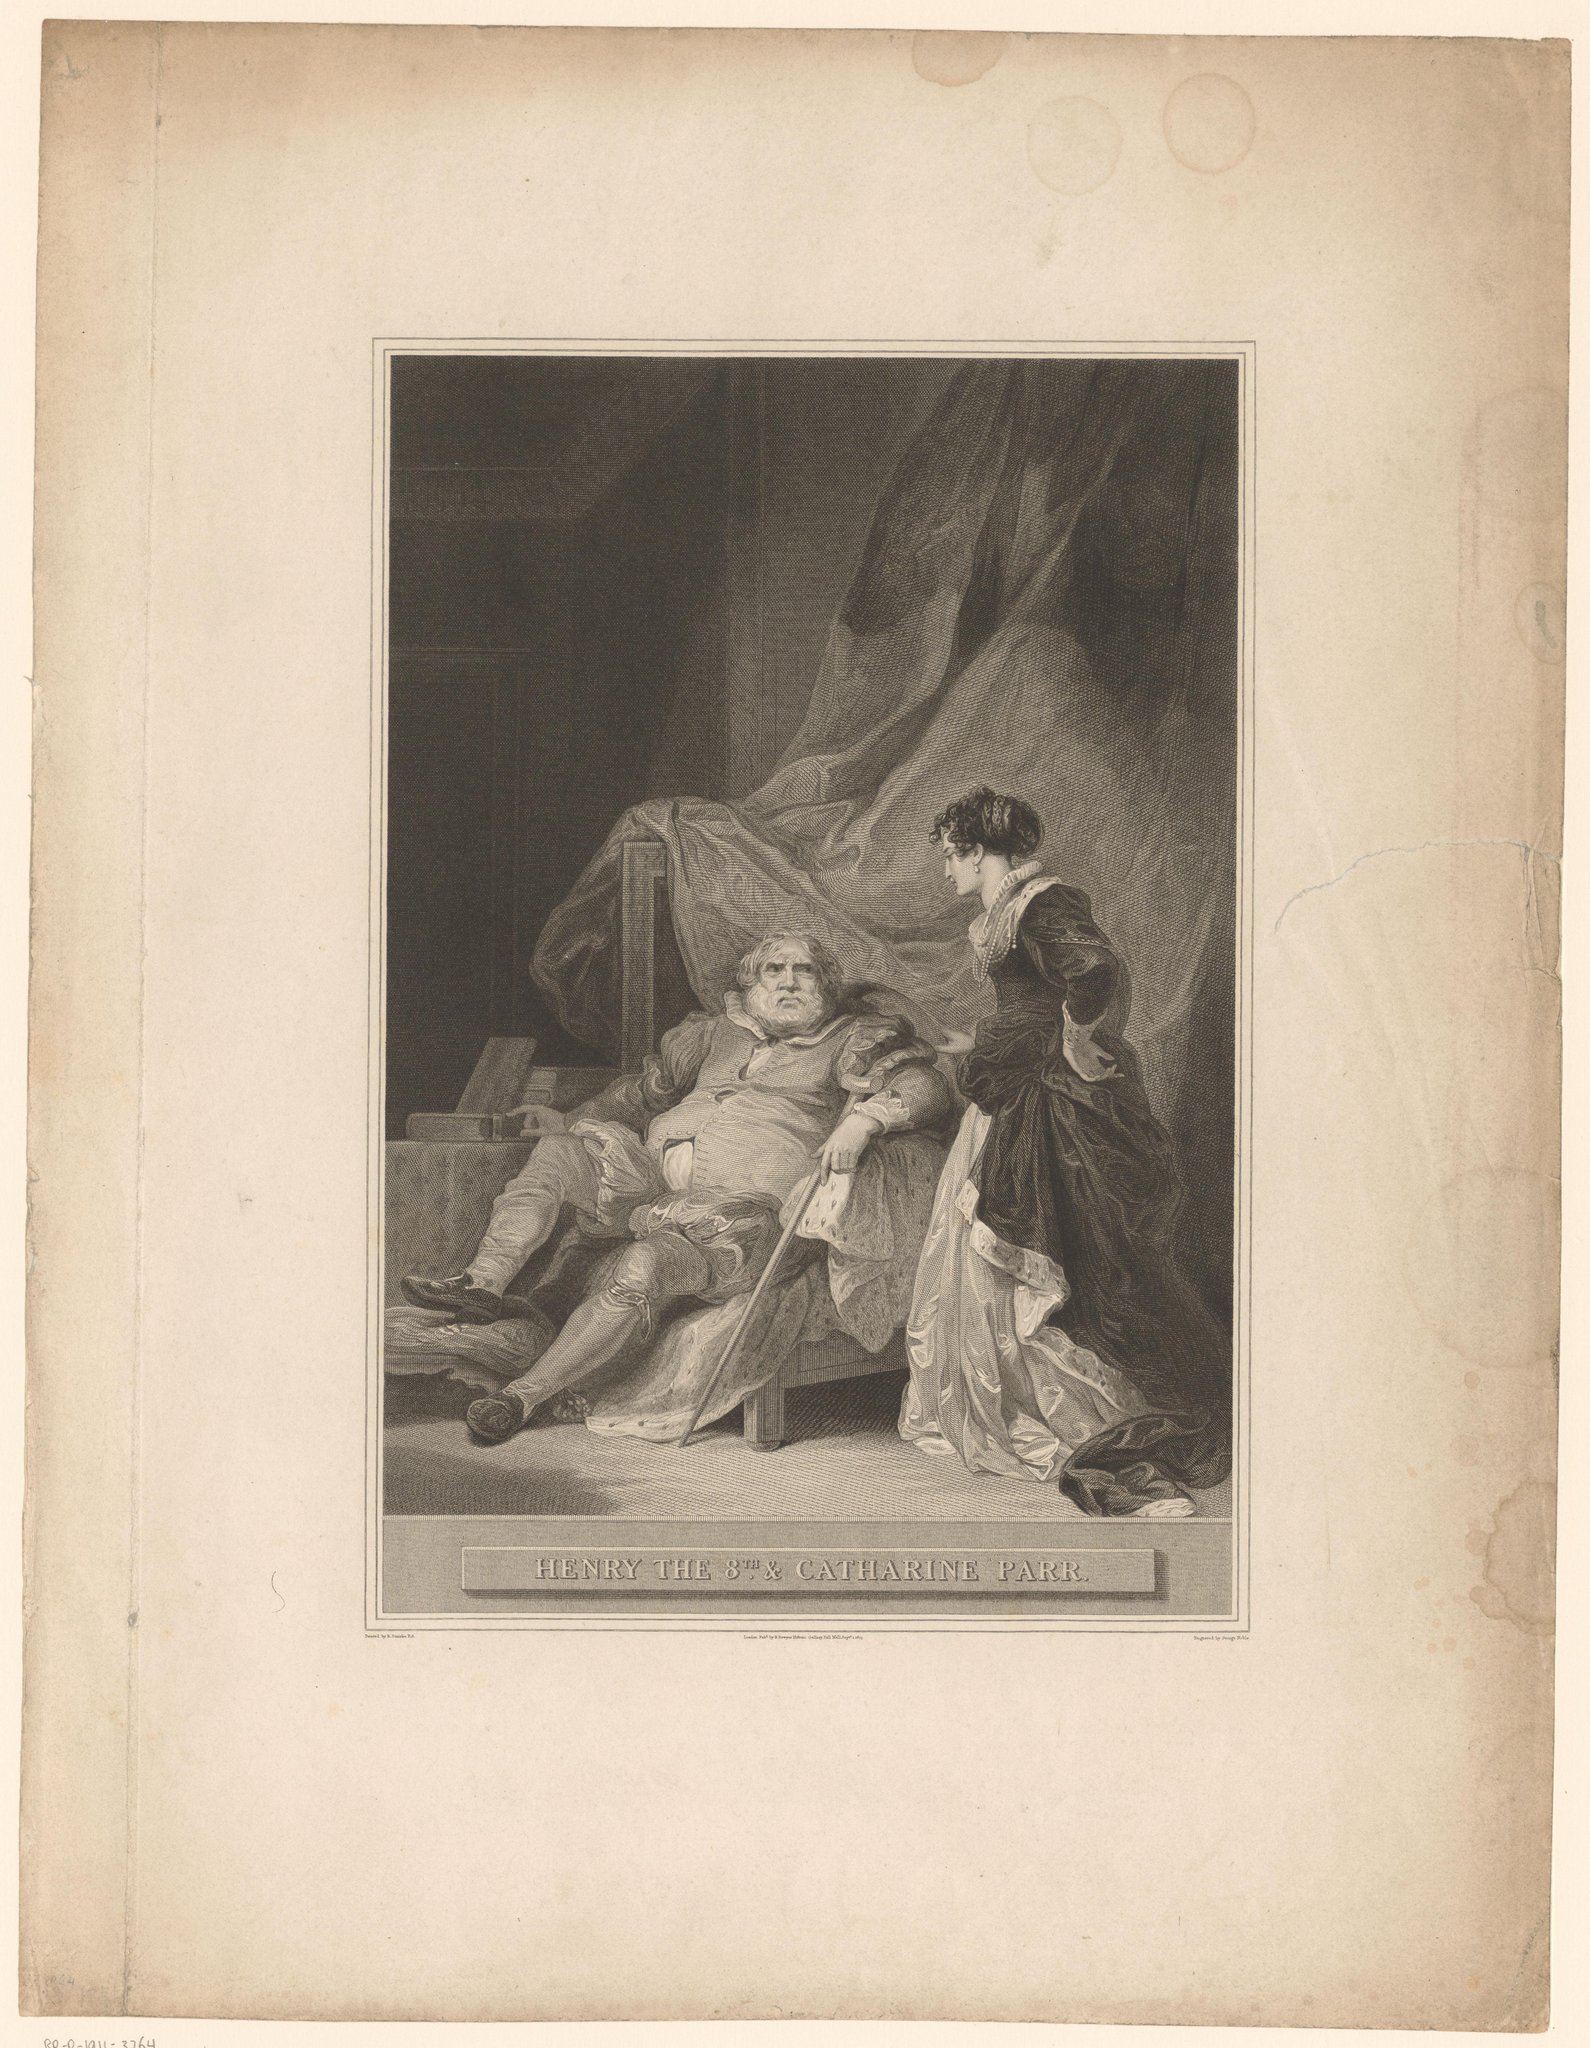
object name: book illustration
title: Henry the 8th. & Catharine Parr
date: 1805-1809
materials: paper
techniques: etching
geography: london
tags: queen, king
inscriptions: collector's mark: Lugt 2228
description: Prent uit: Hume, David. History of England (...). Londen: Robert Bowyer, 1805.